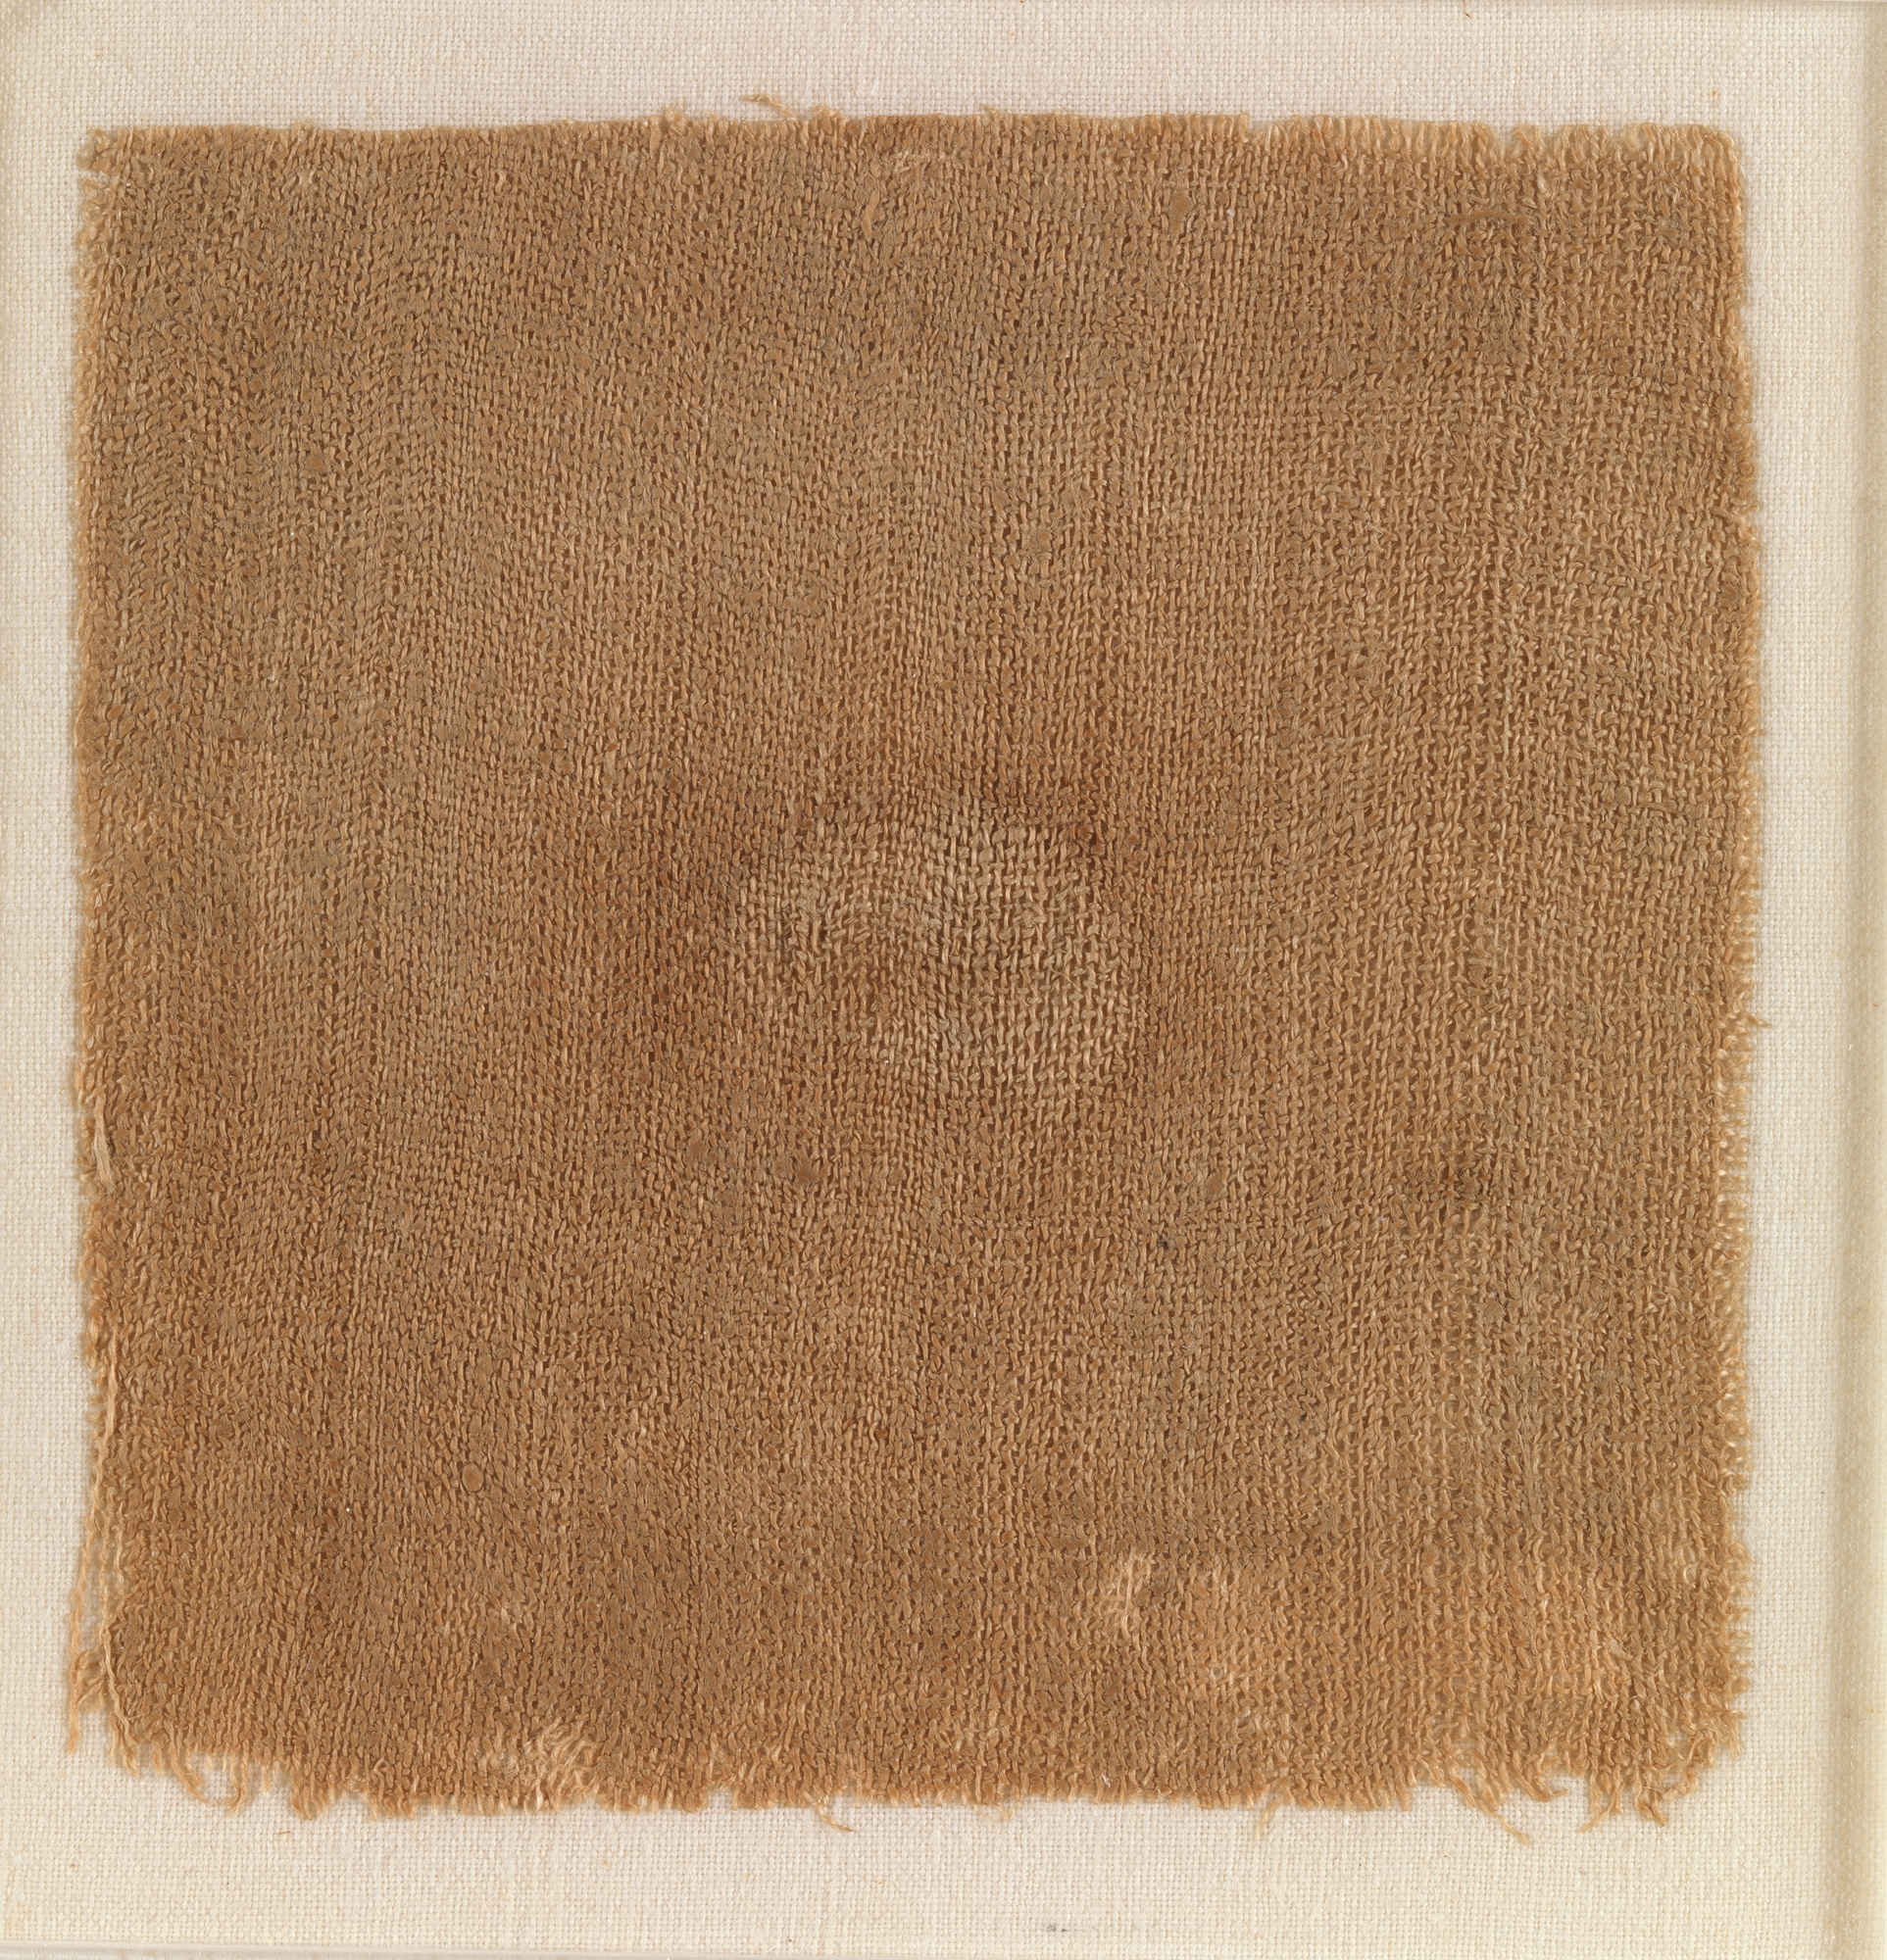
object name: linen sample, adoratrice of hathor henettawy, mummy cloth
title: Mummy Cloth Fragment of the Adoratrice of Hathor Henettawy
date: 1070-945 BCE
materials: linen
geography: egypt